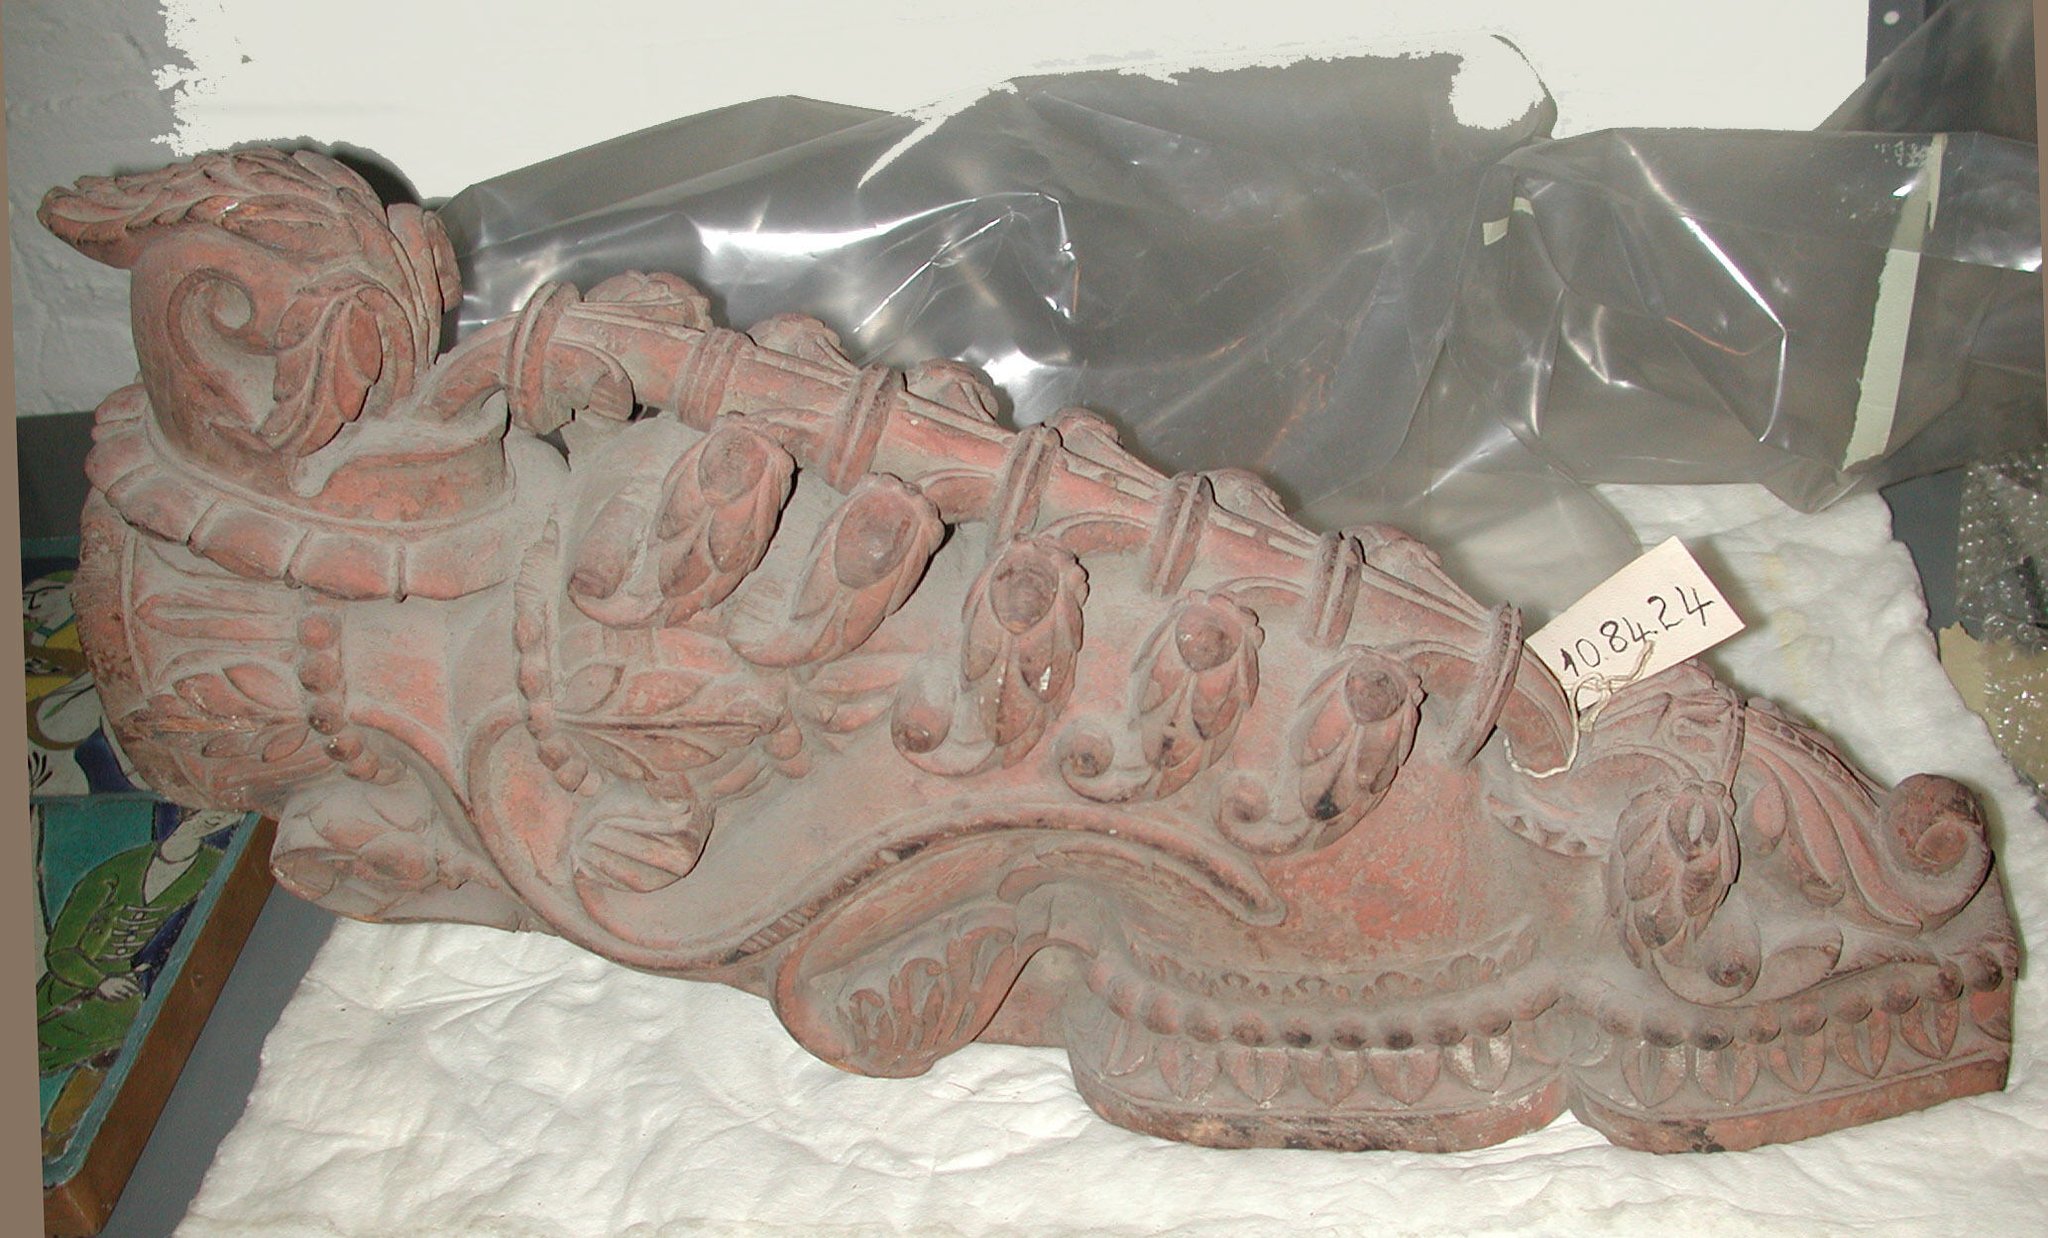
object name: bracket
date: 1501-1700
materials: wood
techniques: carving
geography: india